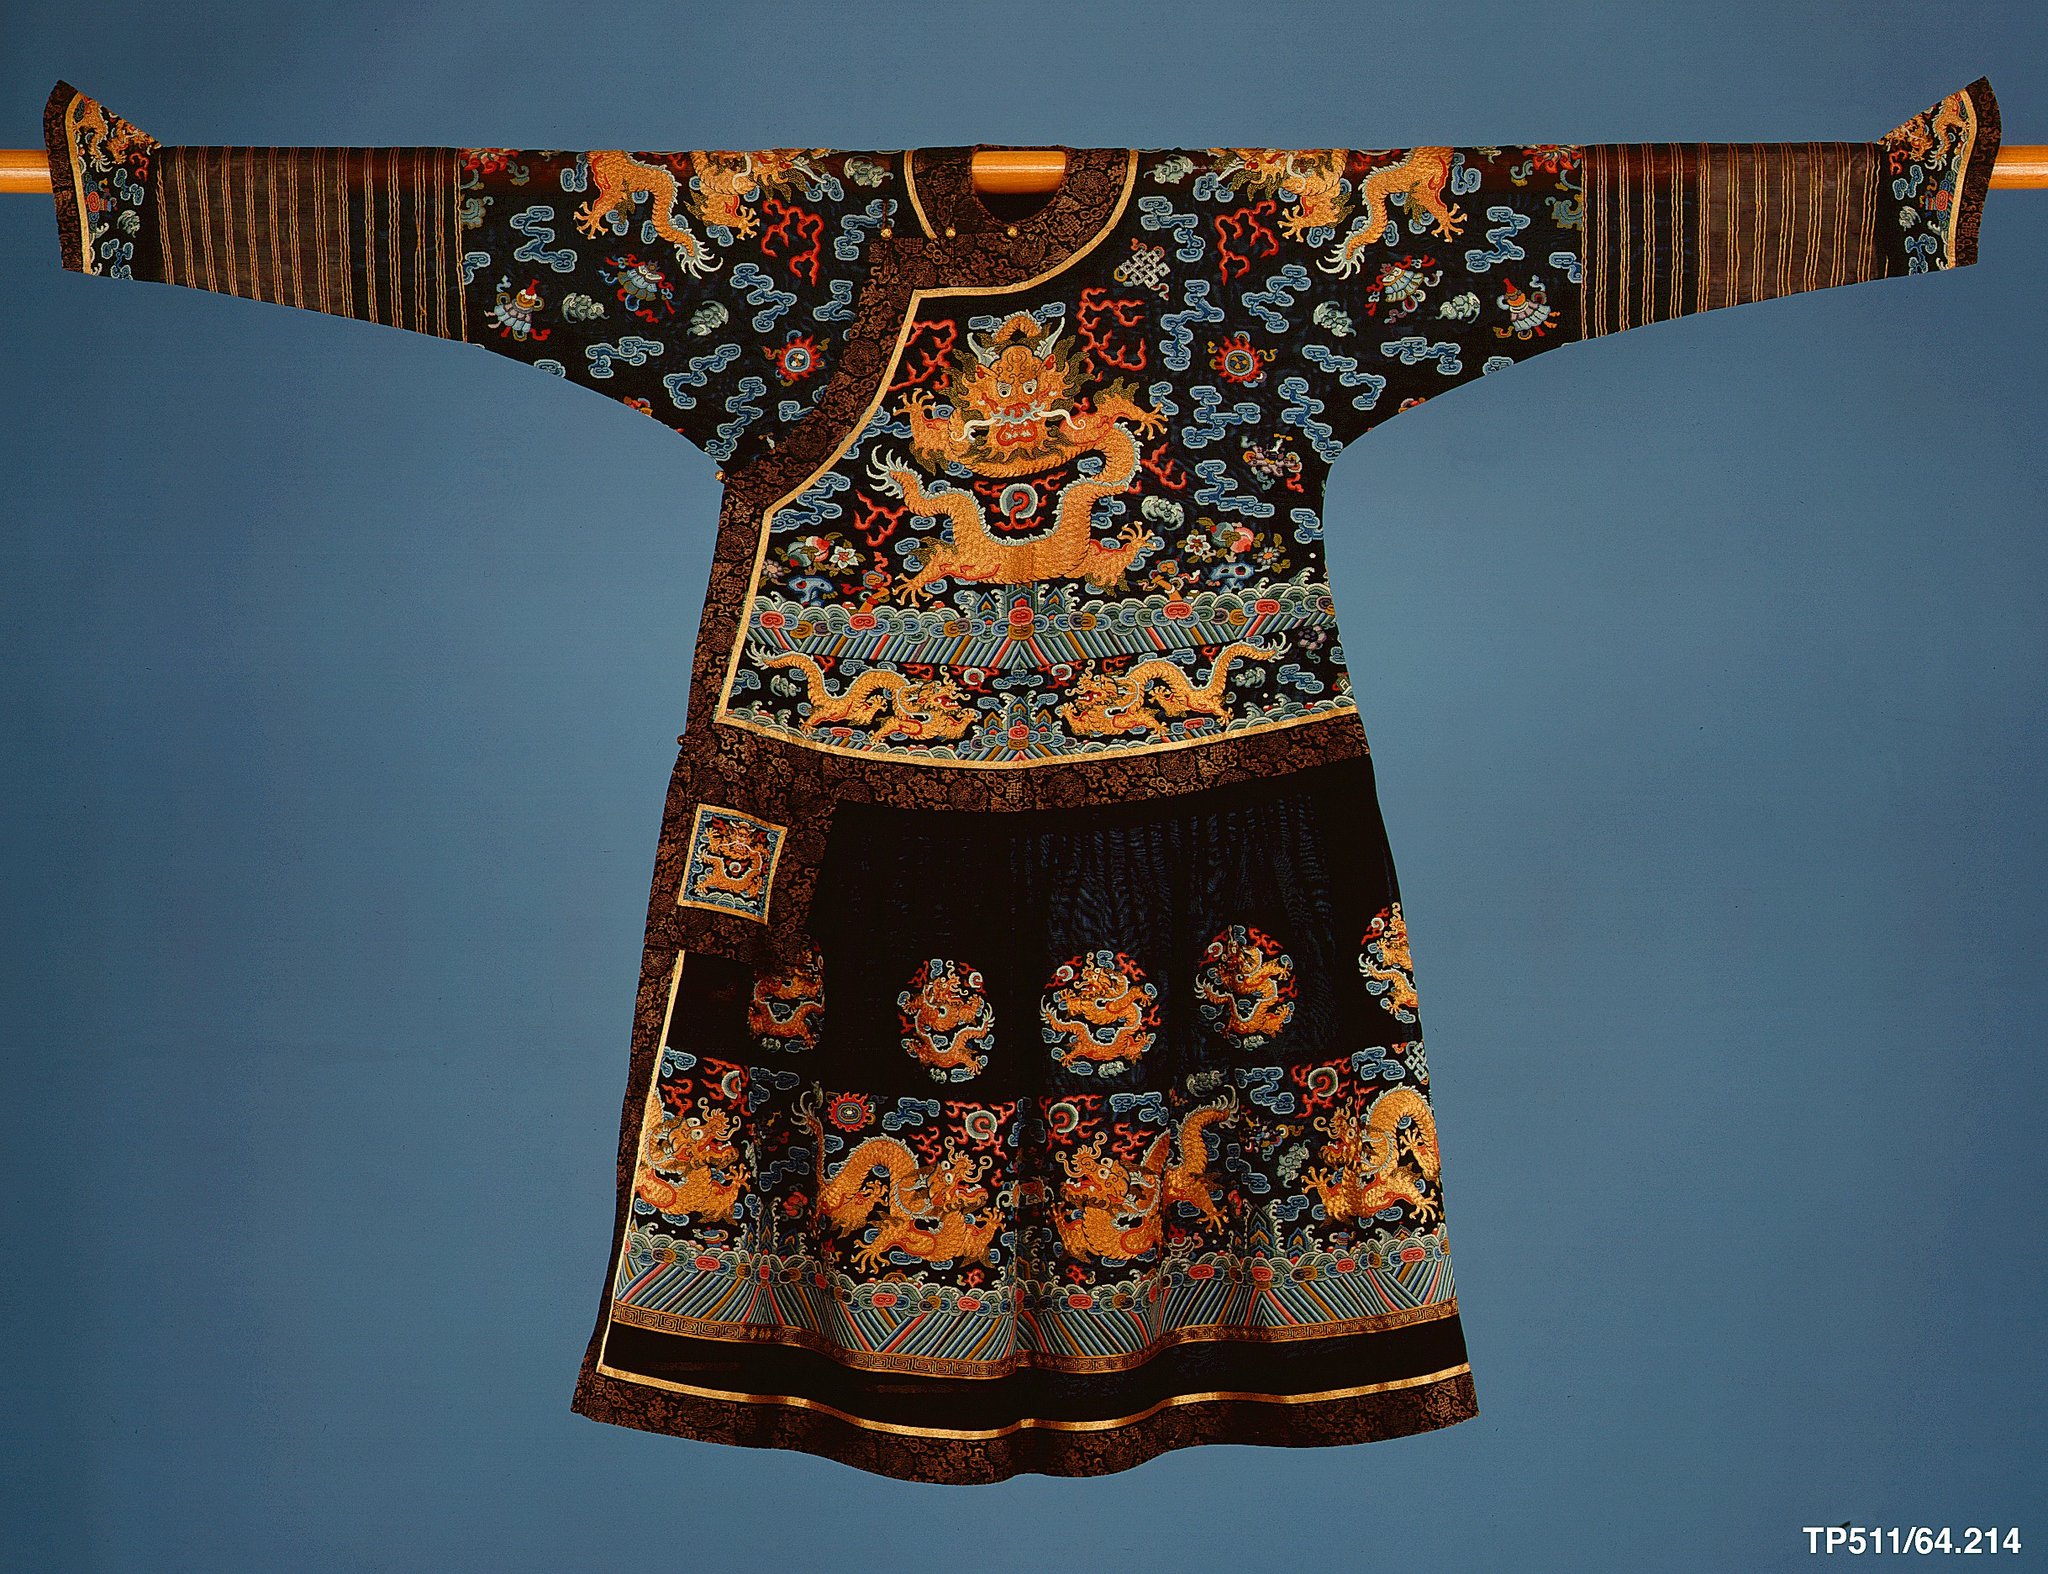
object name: robe of state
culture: chinese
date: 1801-1900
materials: metal thread, silk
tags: dragons